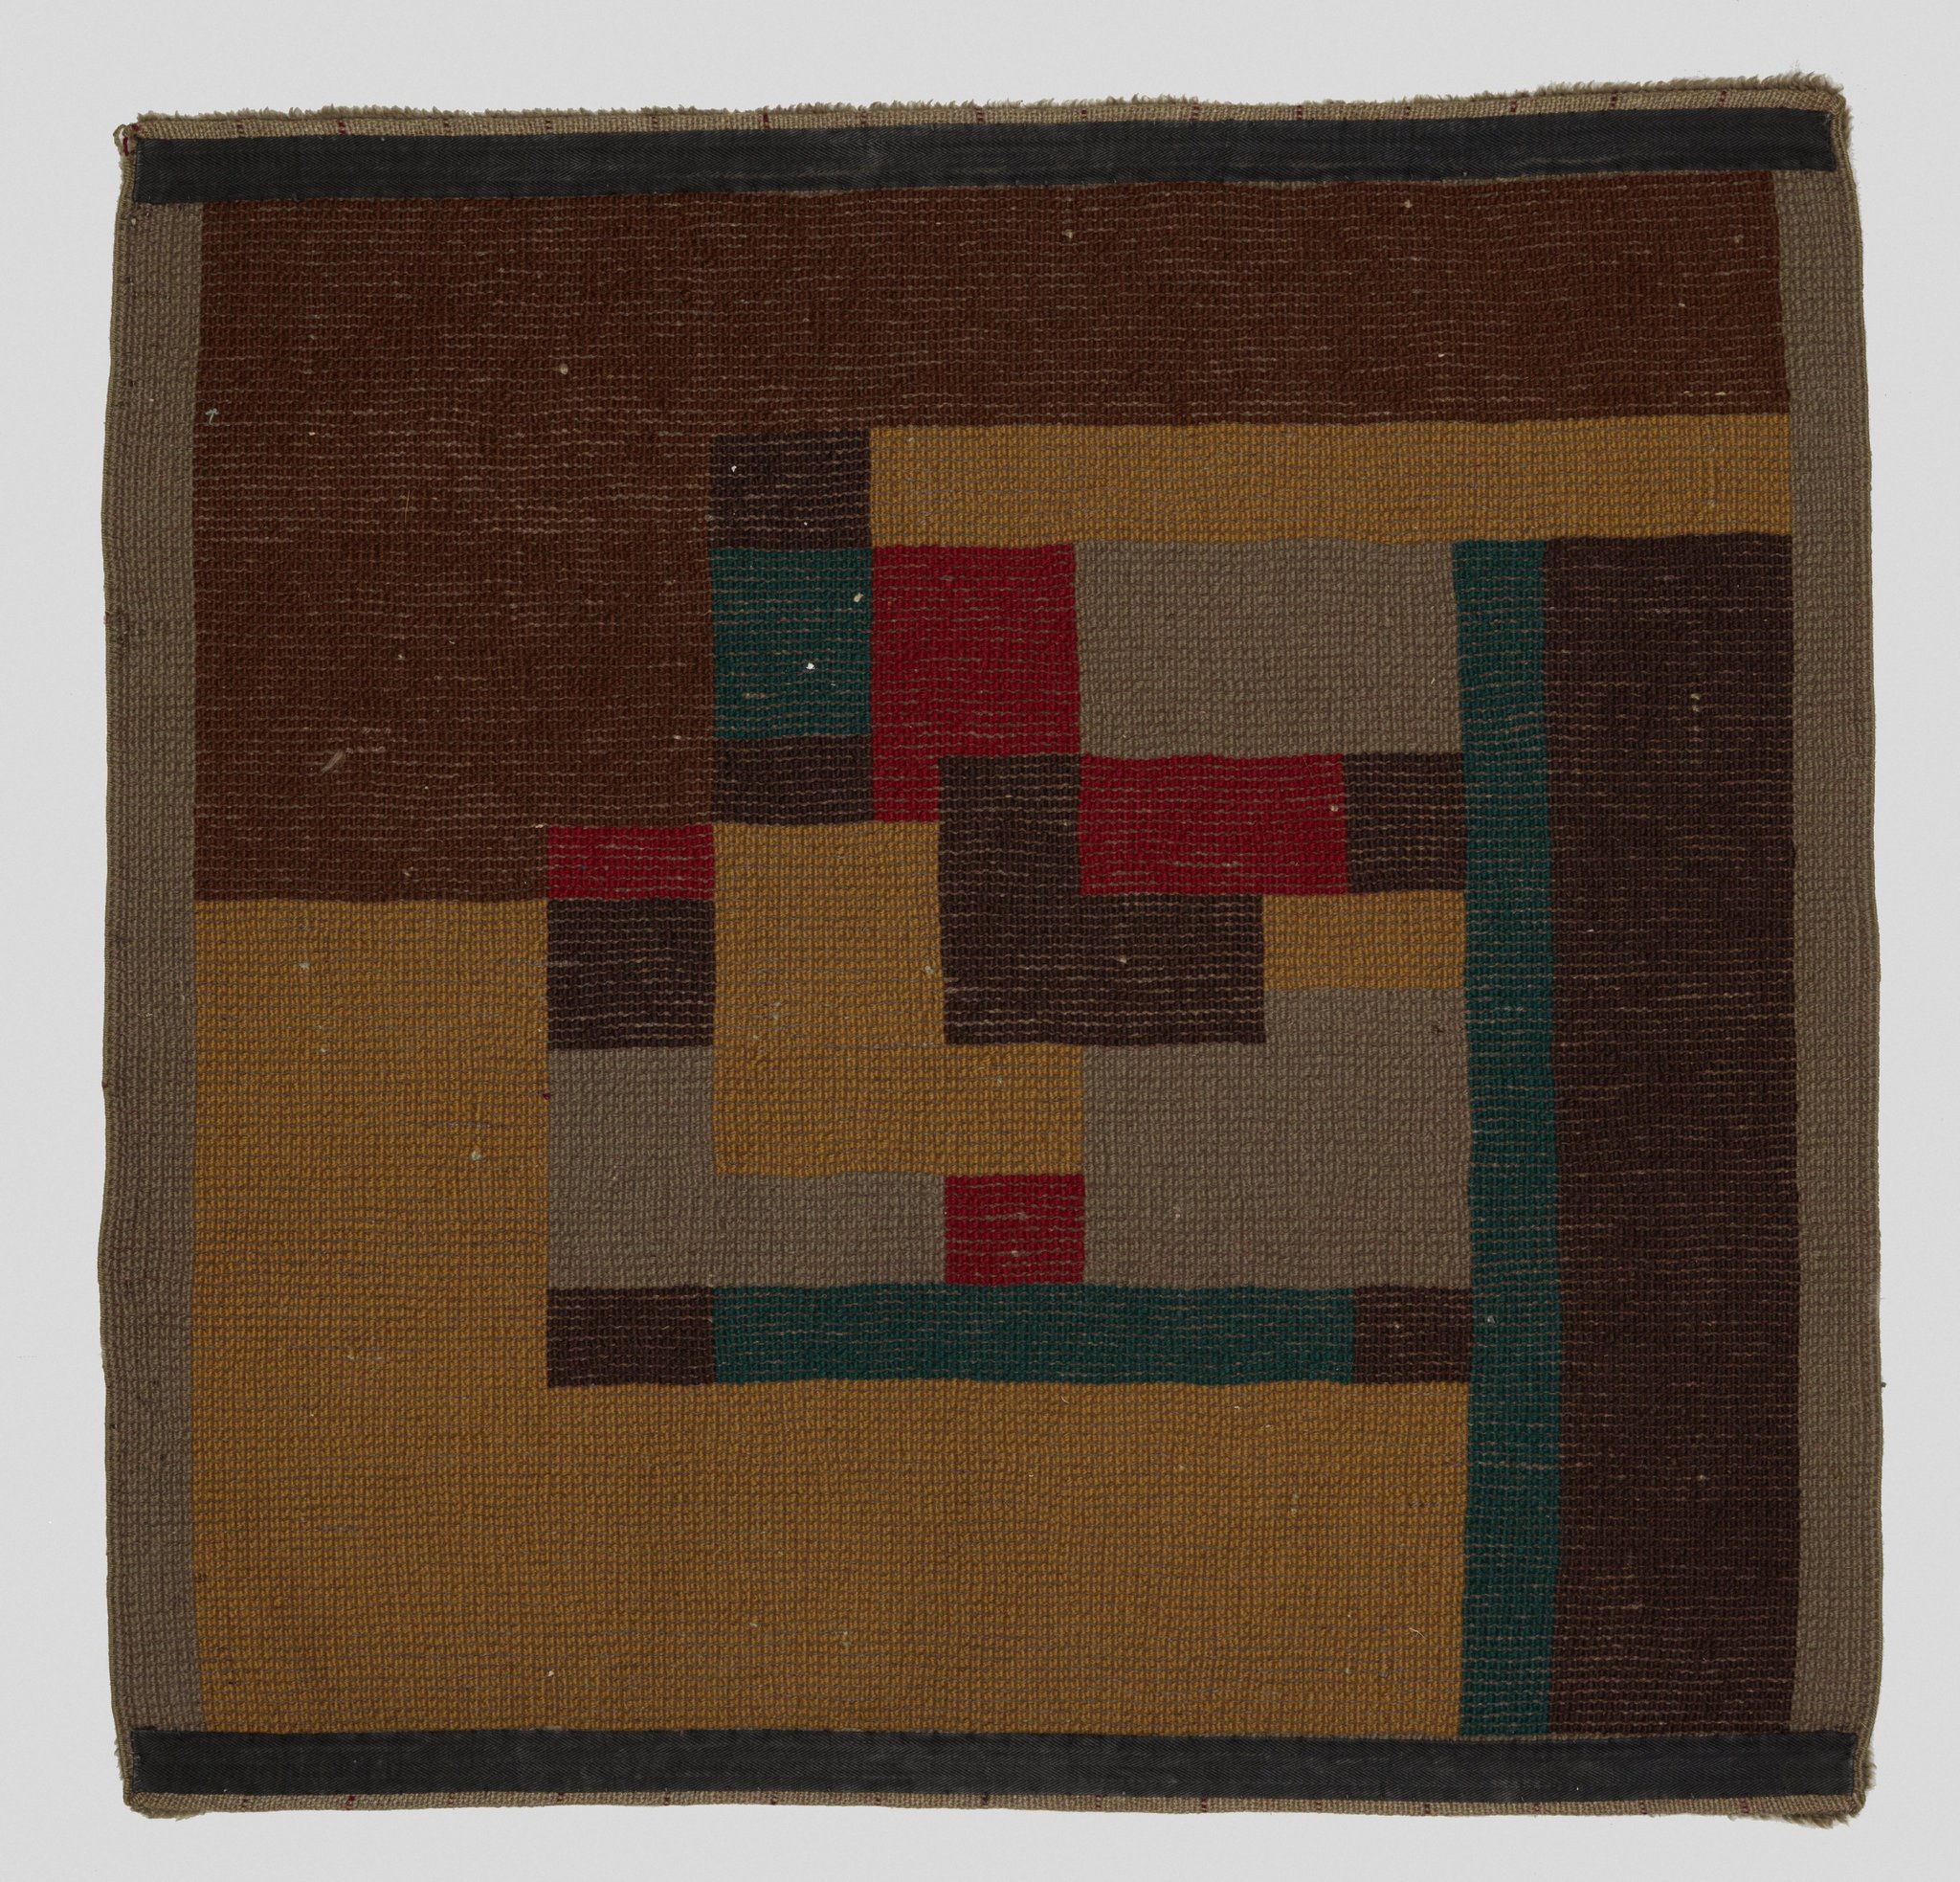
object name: tapijt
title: Vloerkleed van wol met effen blokken en vierkanten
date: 1910-1927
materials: wool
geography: netherlands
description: Vloerkleed van wol met effen blokken en vierkanten, behorende bij kamerinrichting naar ontwerp G.C. Schubad.